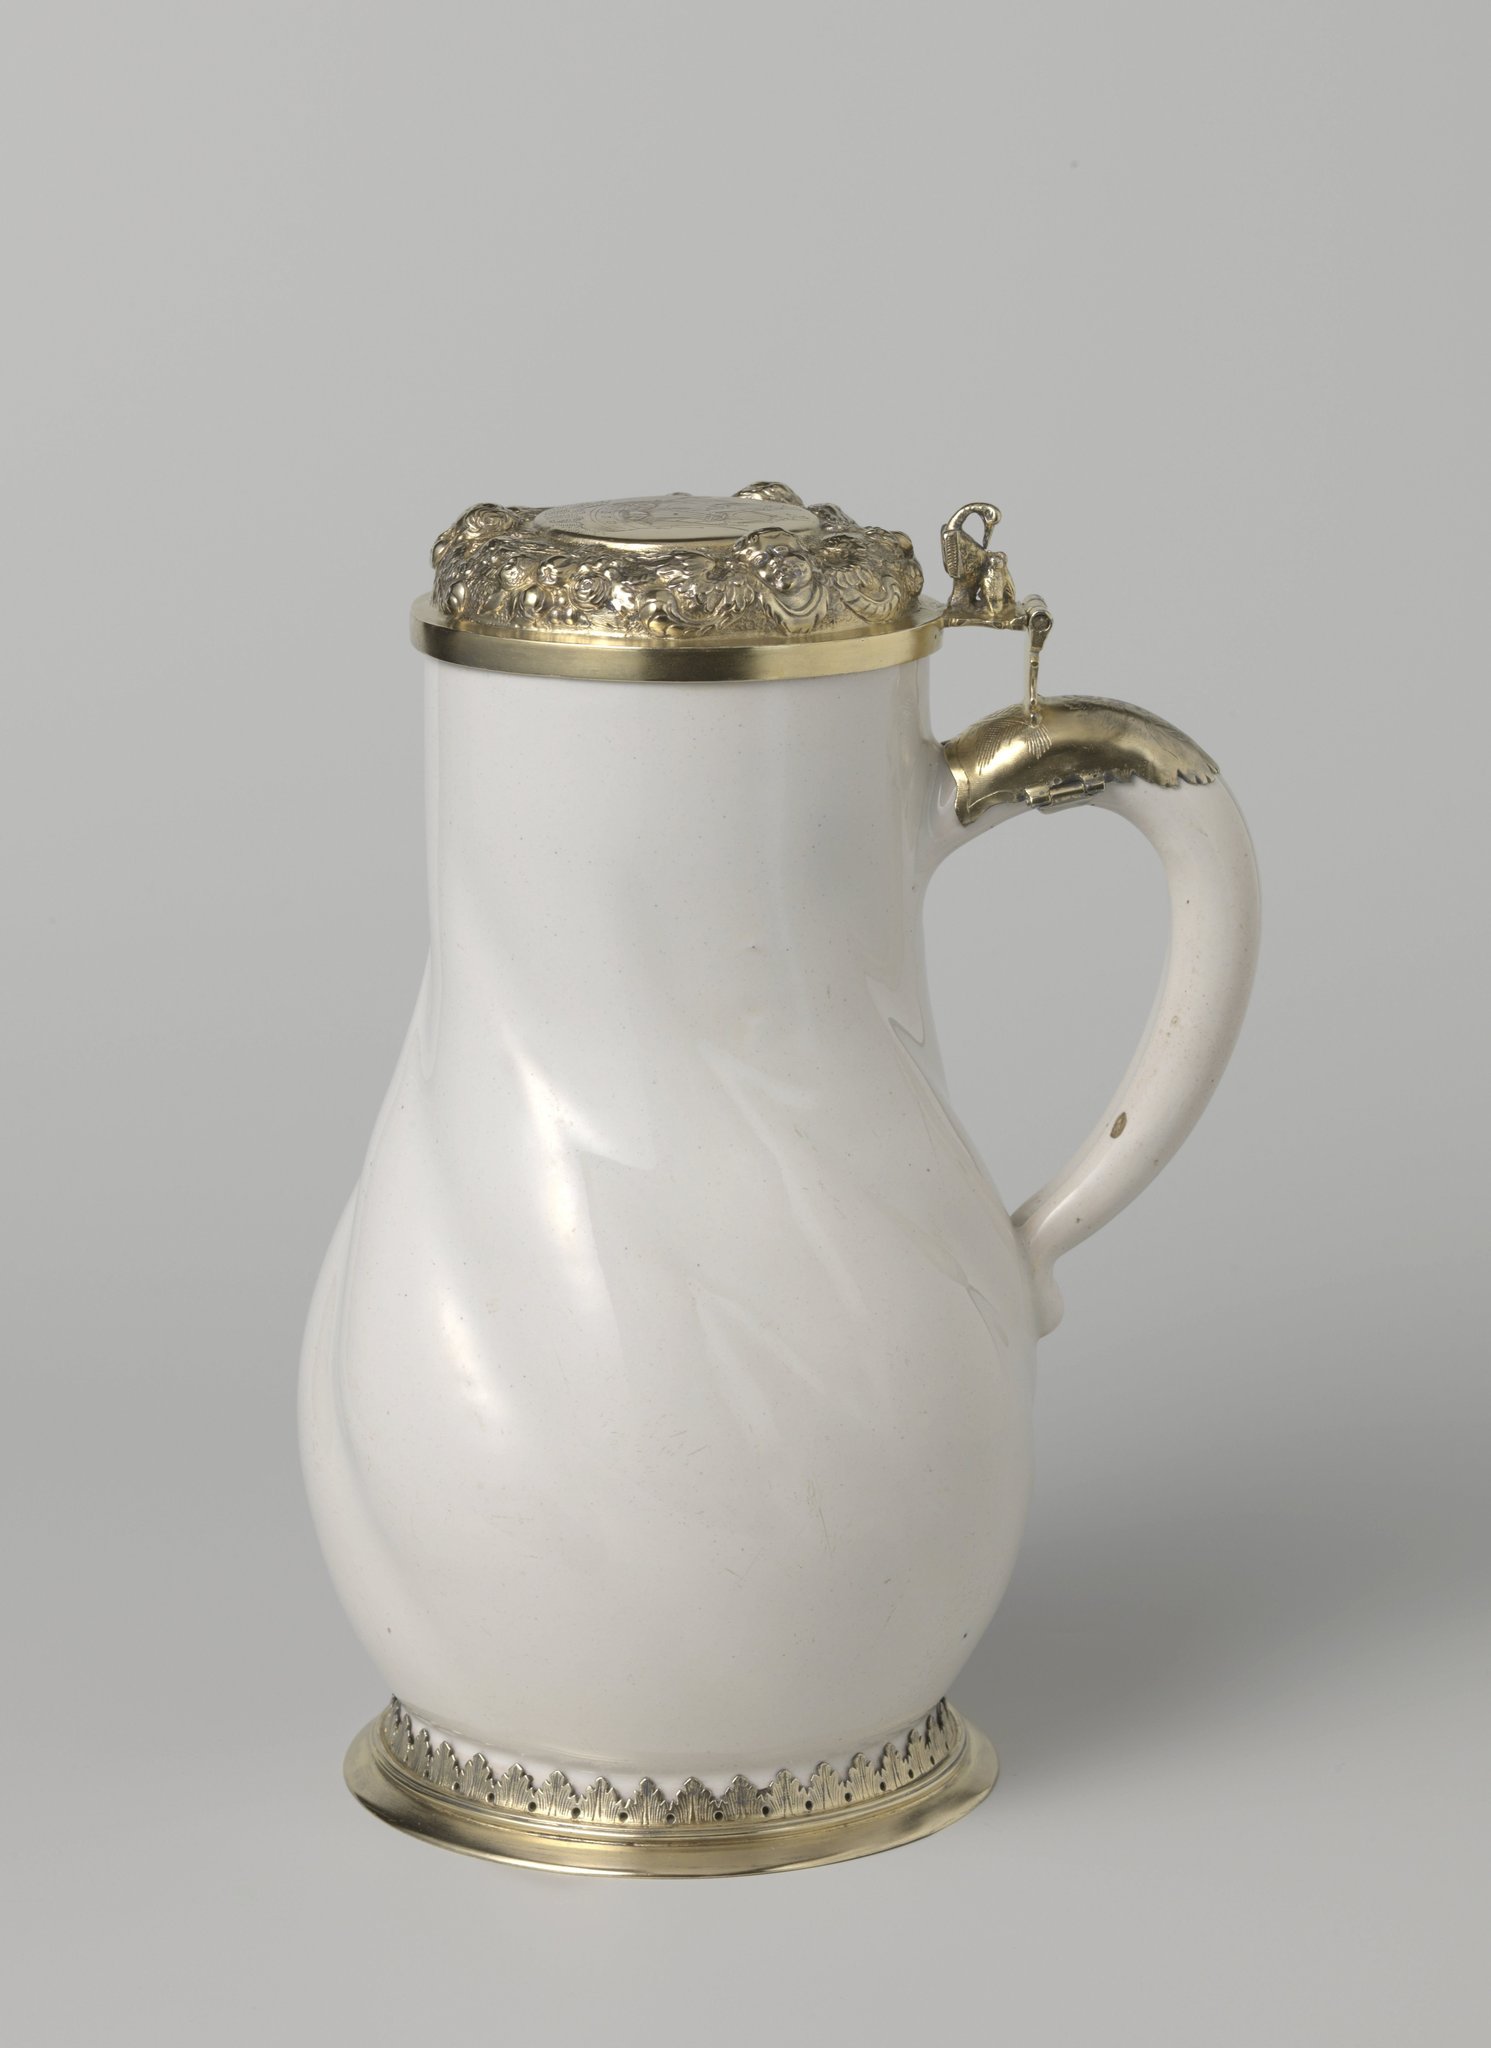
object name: ewer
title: Kan met deksel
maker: Anonymous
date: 1680-1696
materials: earthenware, silver, glaze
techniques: gilding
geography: enkhuizen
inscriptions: maker's mark: ‘onbekend meesterteken’, town mark: ‘stadskeur Enkhuizen’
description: Kan van faience met verguld zilveren deksel. Wit geglazuurd.